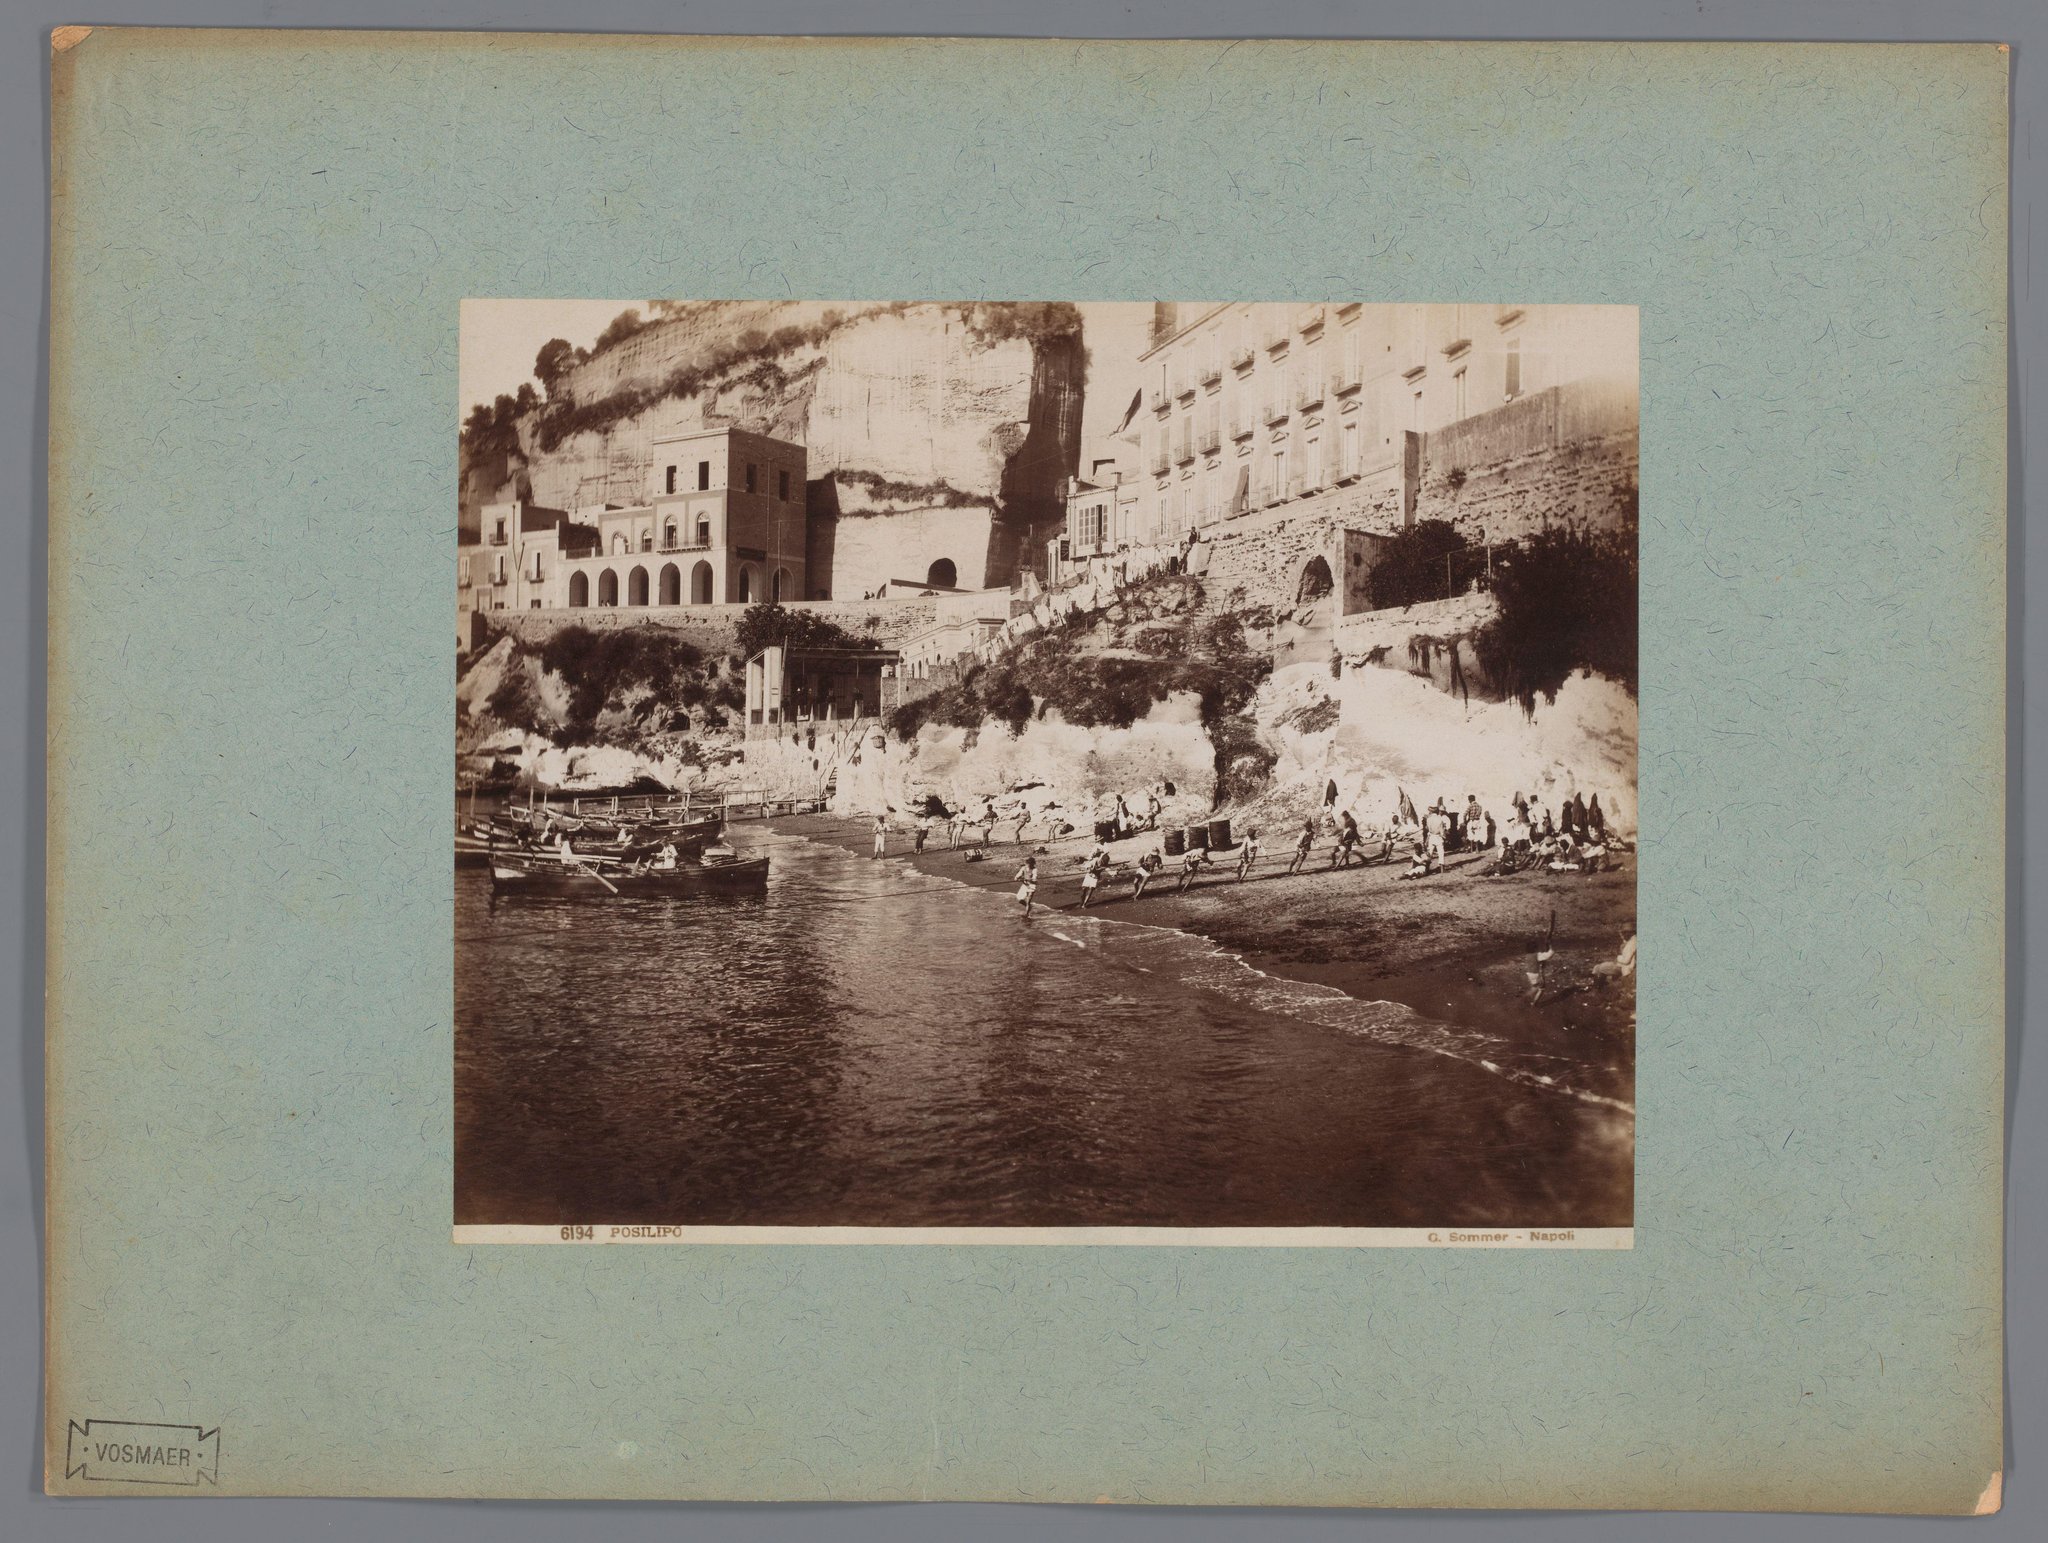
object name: photograph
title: Vissersboten die bij Posillipo op het strand worden getrokken, Italië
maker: giorgio sommer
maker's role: fotograaf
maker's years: 1834-1914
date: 1856-1914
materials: cardboard, paper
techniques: albumen print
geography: posillipo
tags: urban housing, ships (in general), coast (in tropical and sub-tropical regions), fisherman, posillipo, collina di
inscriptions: number: ‘6194’, collector's mark: ‘VOSMAER’